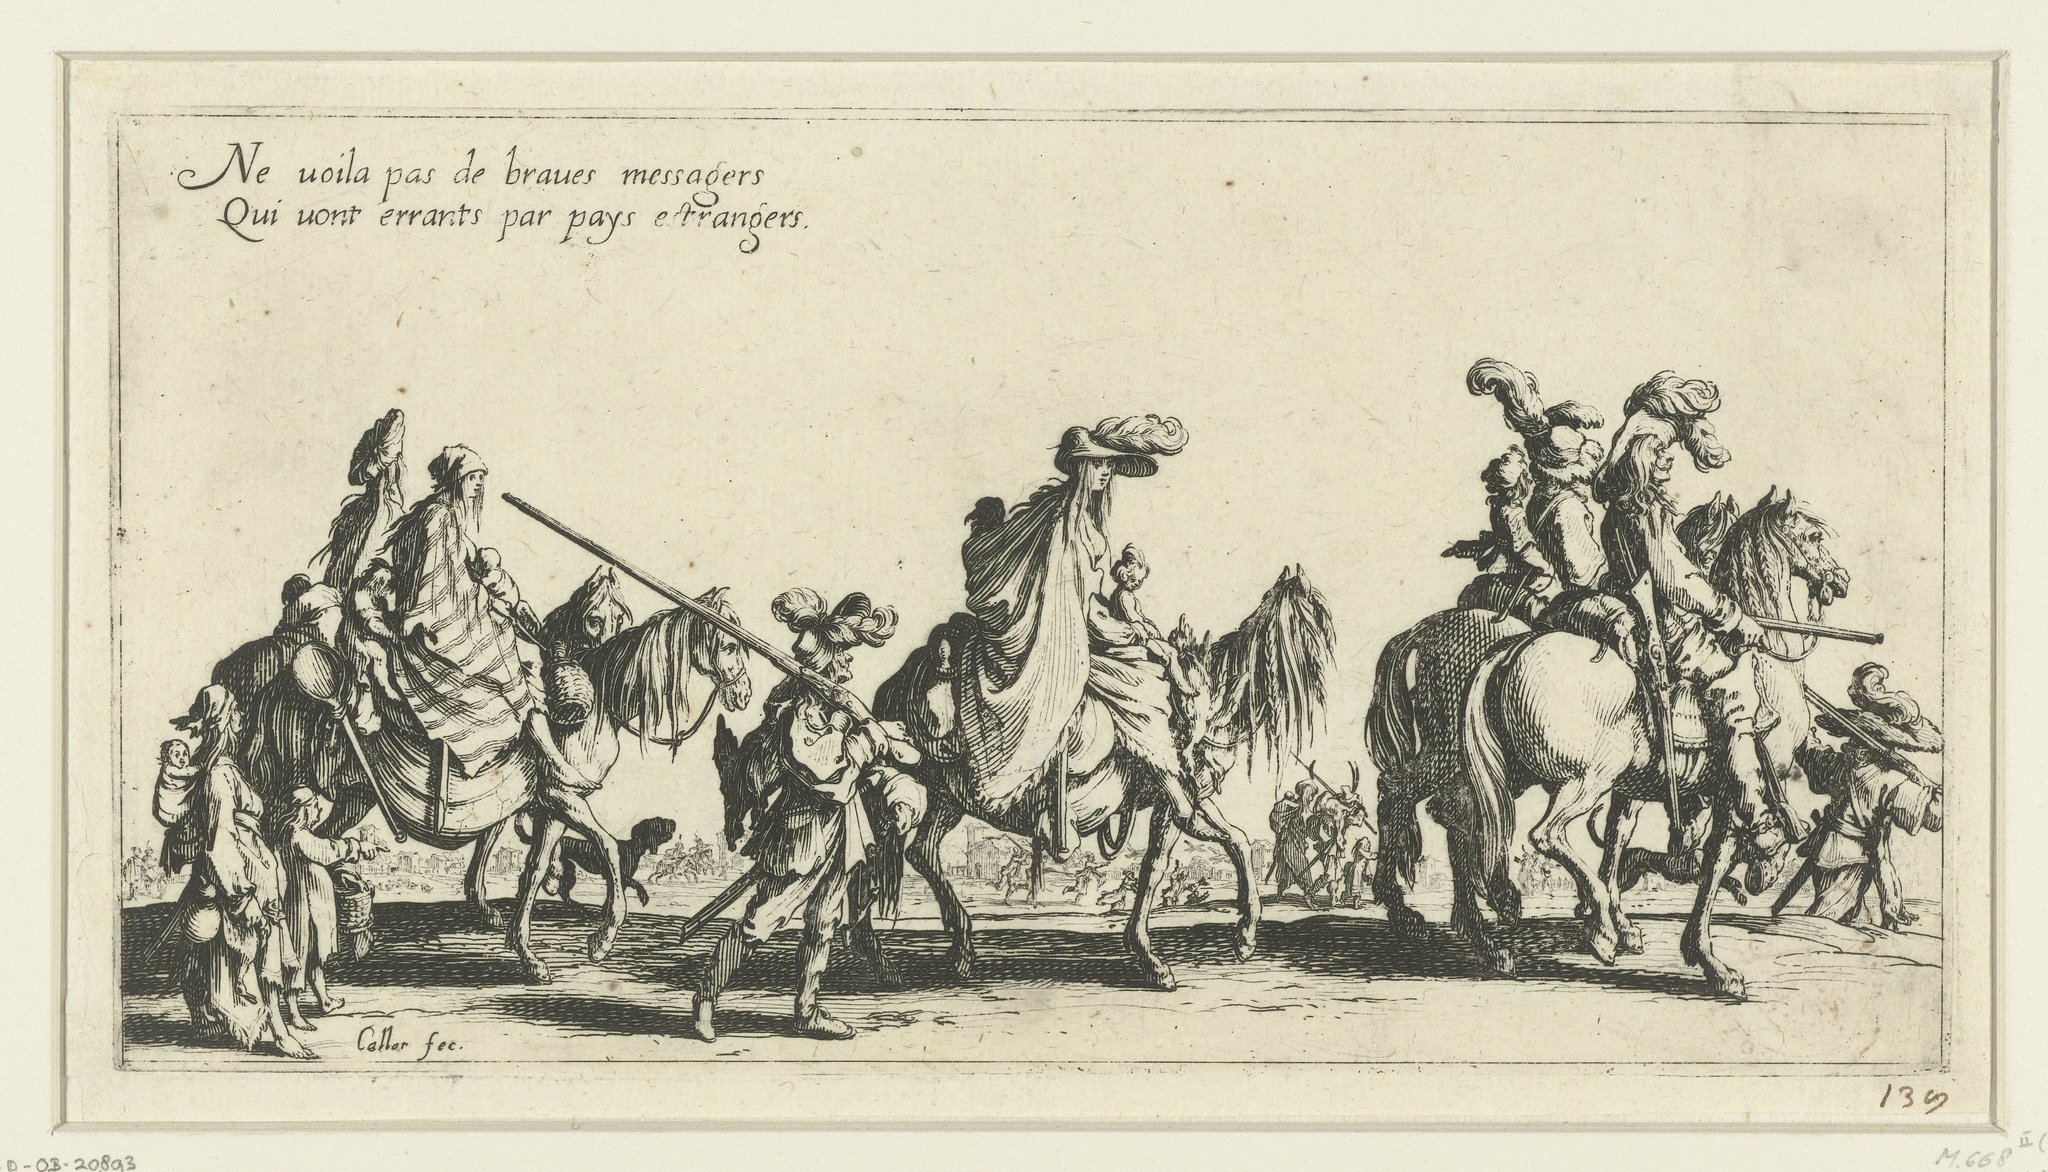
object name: print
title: Roma met paarden onderweg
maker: jacques callot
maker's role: draughtsman, print maker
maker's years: 1592-1635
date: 1621-1631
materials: paper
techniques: engraving, etching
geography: nancy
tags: riding a horse, ass, or mule; rider, horseman, wandering communities: romani or roma, travelling; tourism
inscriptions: collector's mark: Lugt 240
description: Een groep zigeuners onderweg. Uiterst rechts, als voorste van de groep, loopt een man met een geweer. Achter hem rijden twee ruiters. Daarachter drie vrouwen met kinderen te paard. Bovenin de voorstelling twee regels Franse tekst. Deze prent is onderdeel van een serie van vier prenten met voorstellingen van het leven van zigeuners.